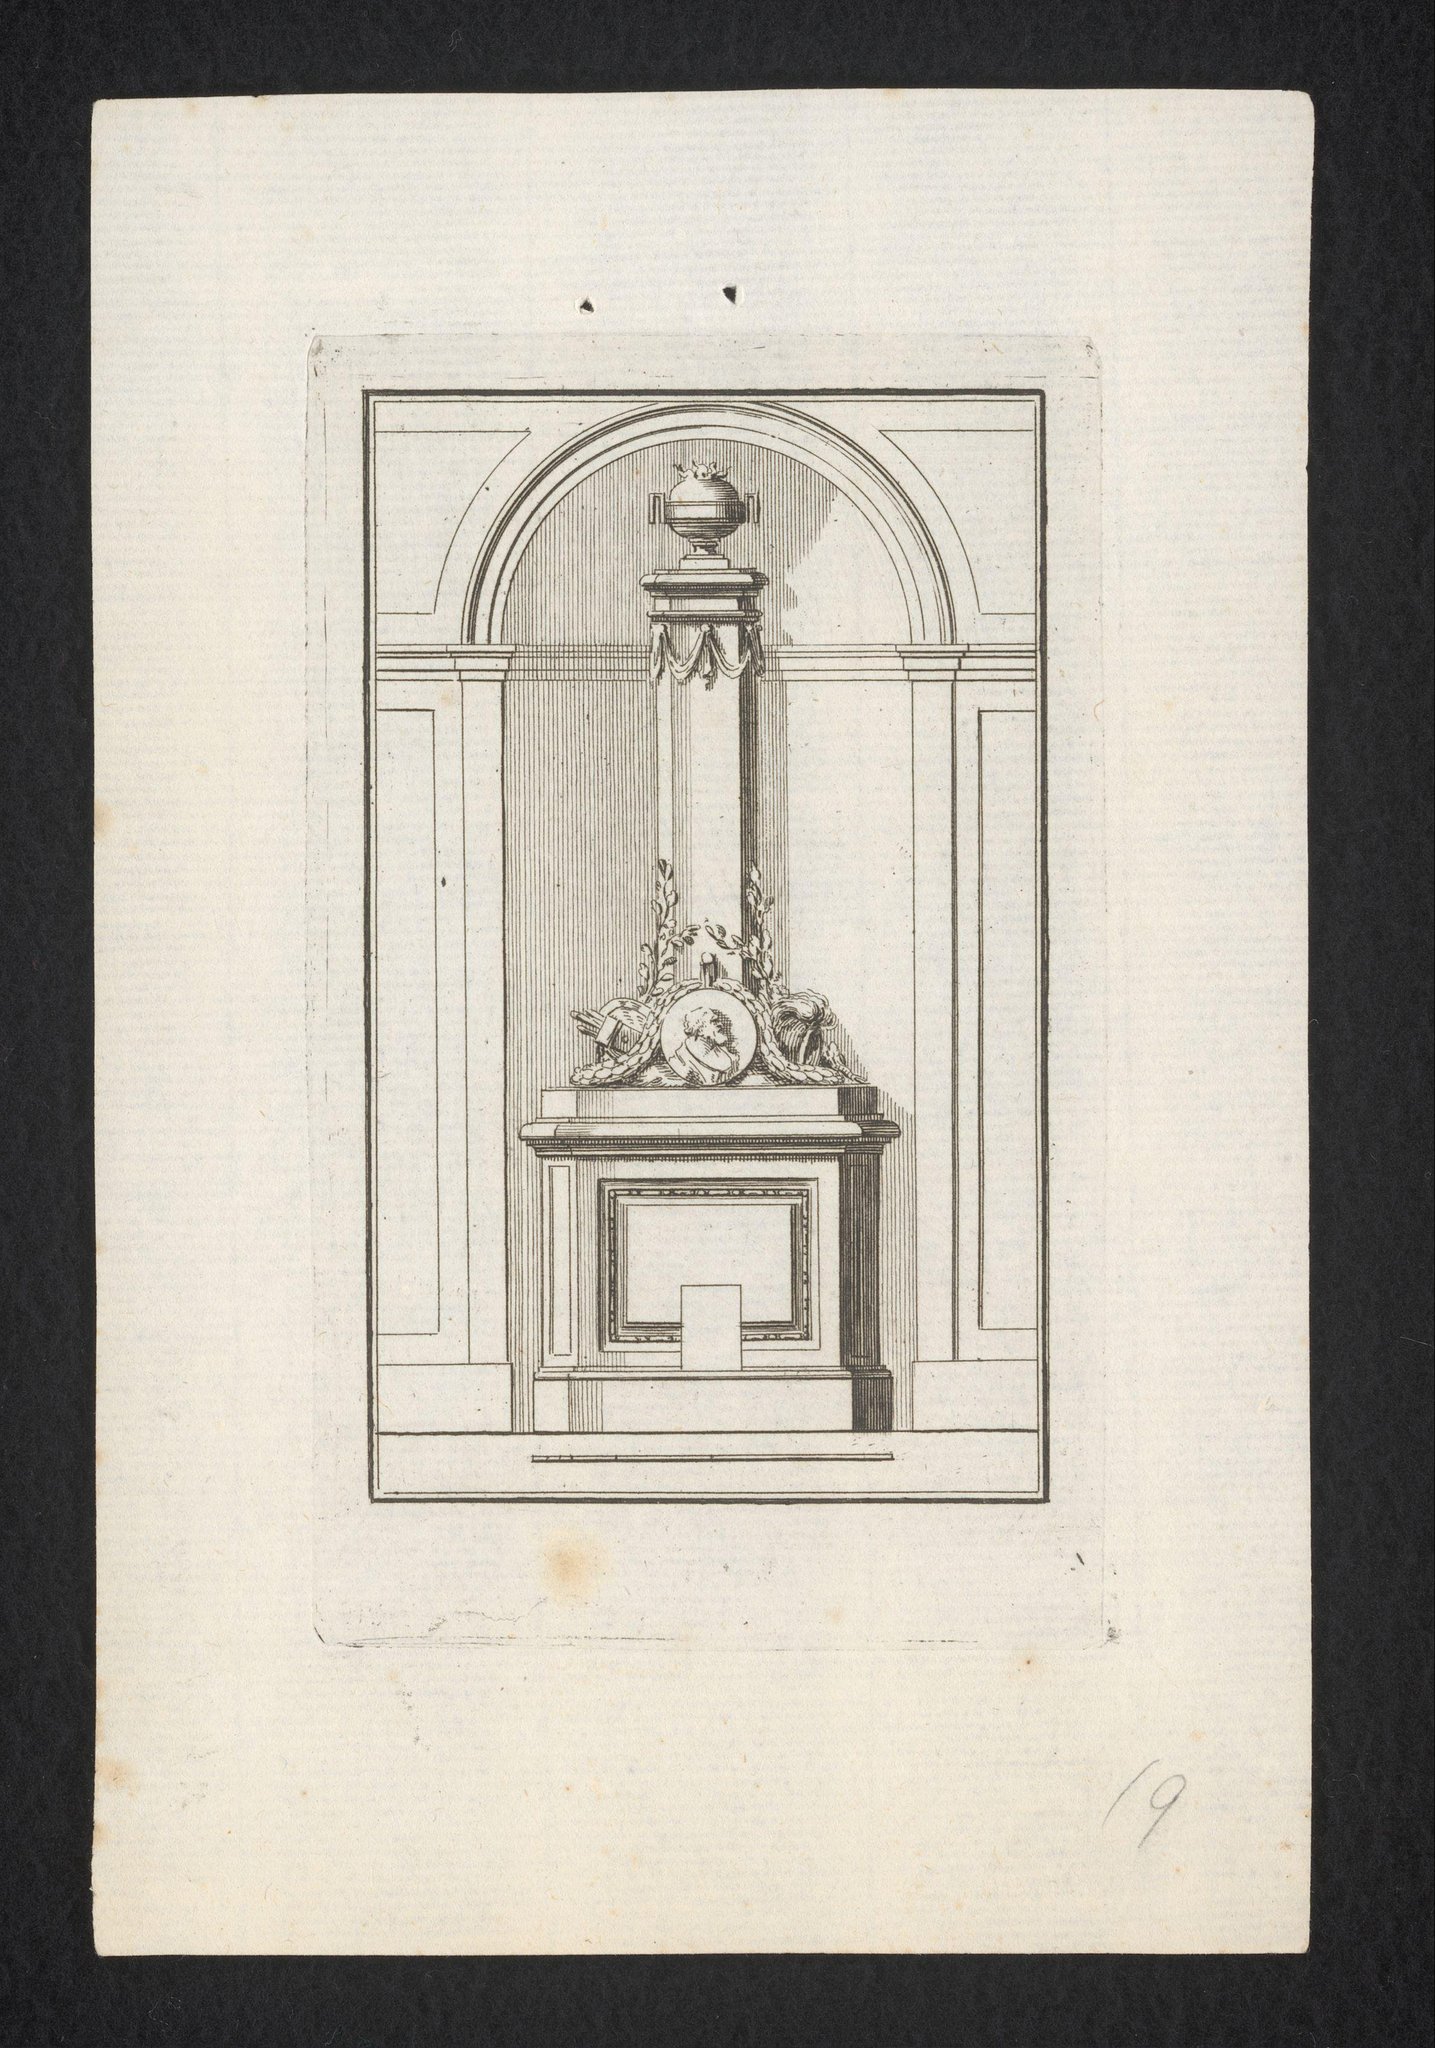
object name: print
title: Haard met vaas op zuil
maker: Anonymous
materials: paper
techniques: etching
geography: paris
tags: column, pillar ~ architecture, vase ~ ornament, hearth and stove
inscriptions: collector's mark: Lugt 2760, collector's mark: Lugt 2228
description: Ontwerp voor een haard of kachel met een vaas op een zuil, daaronder een medaillon met mannenportret en profil omgeven door ranken en wapens.